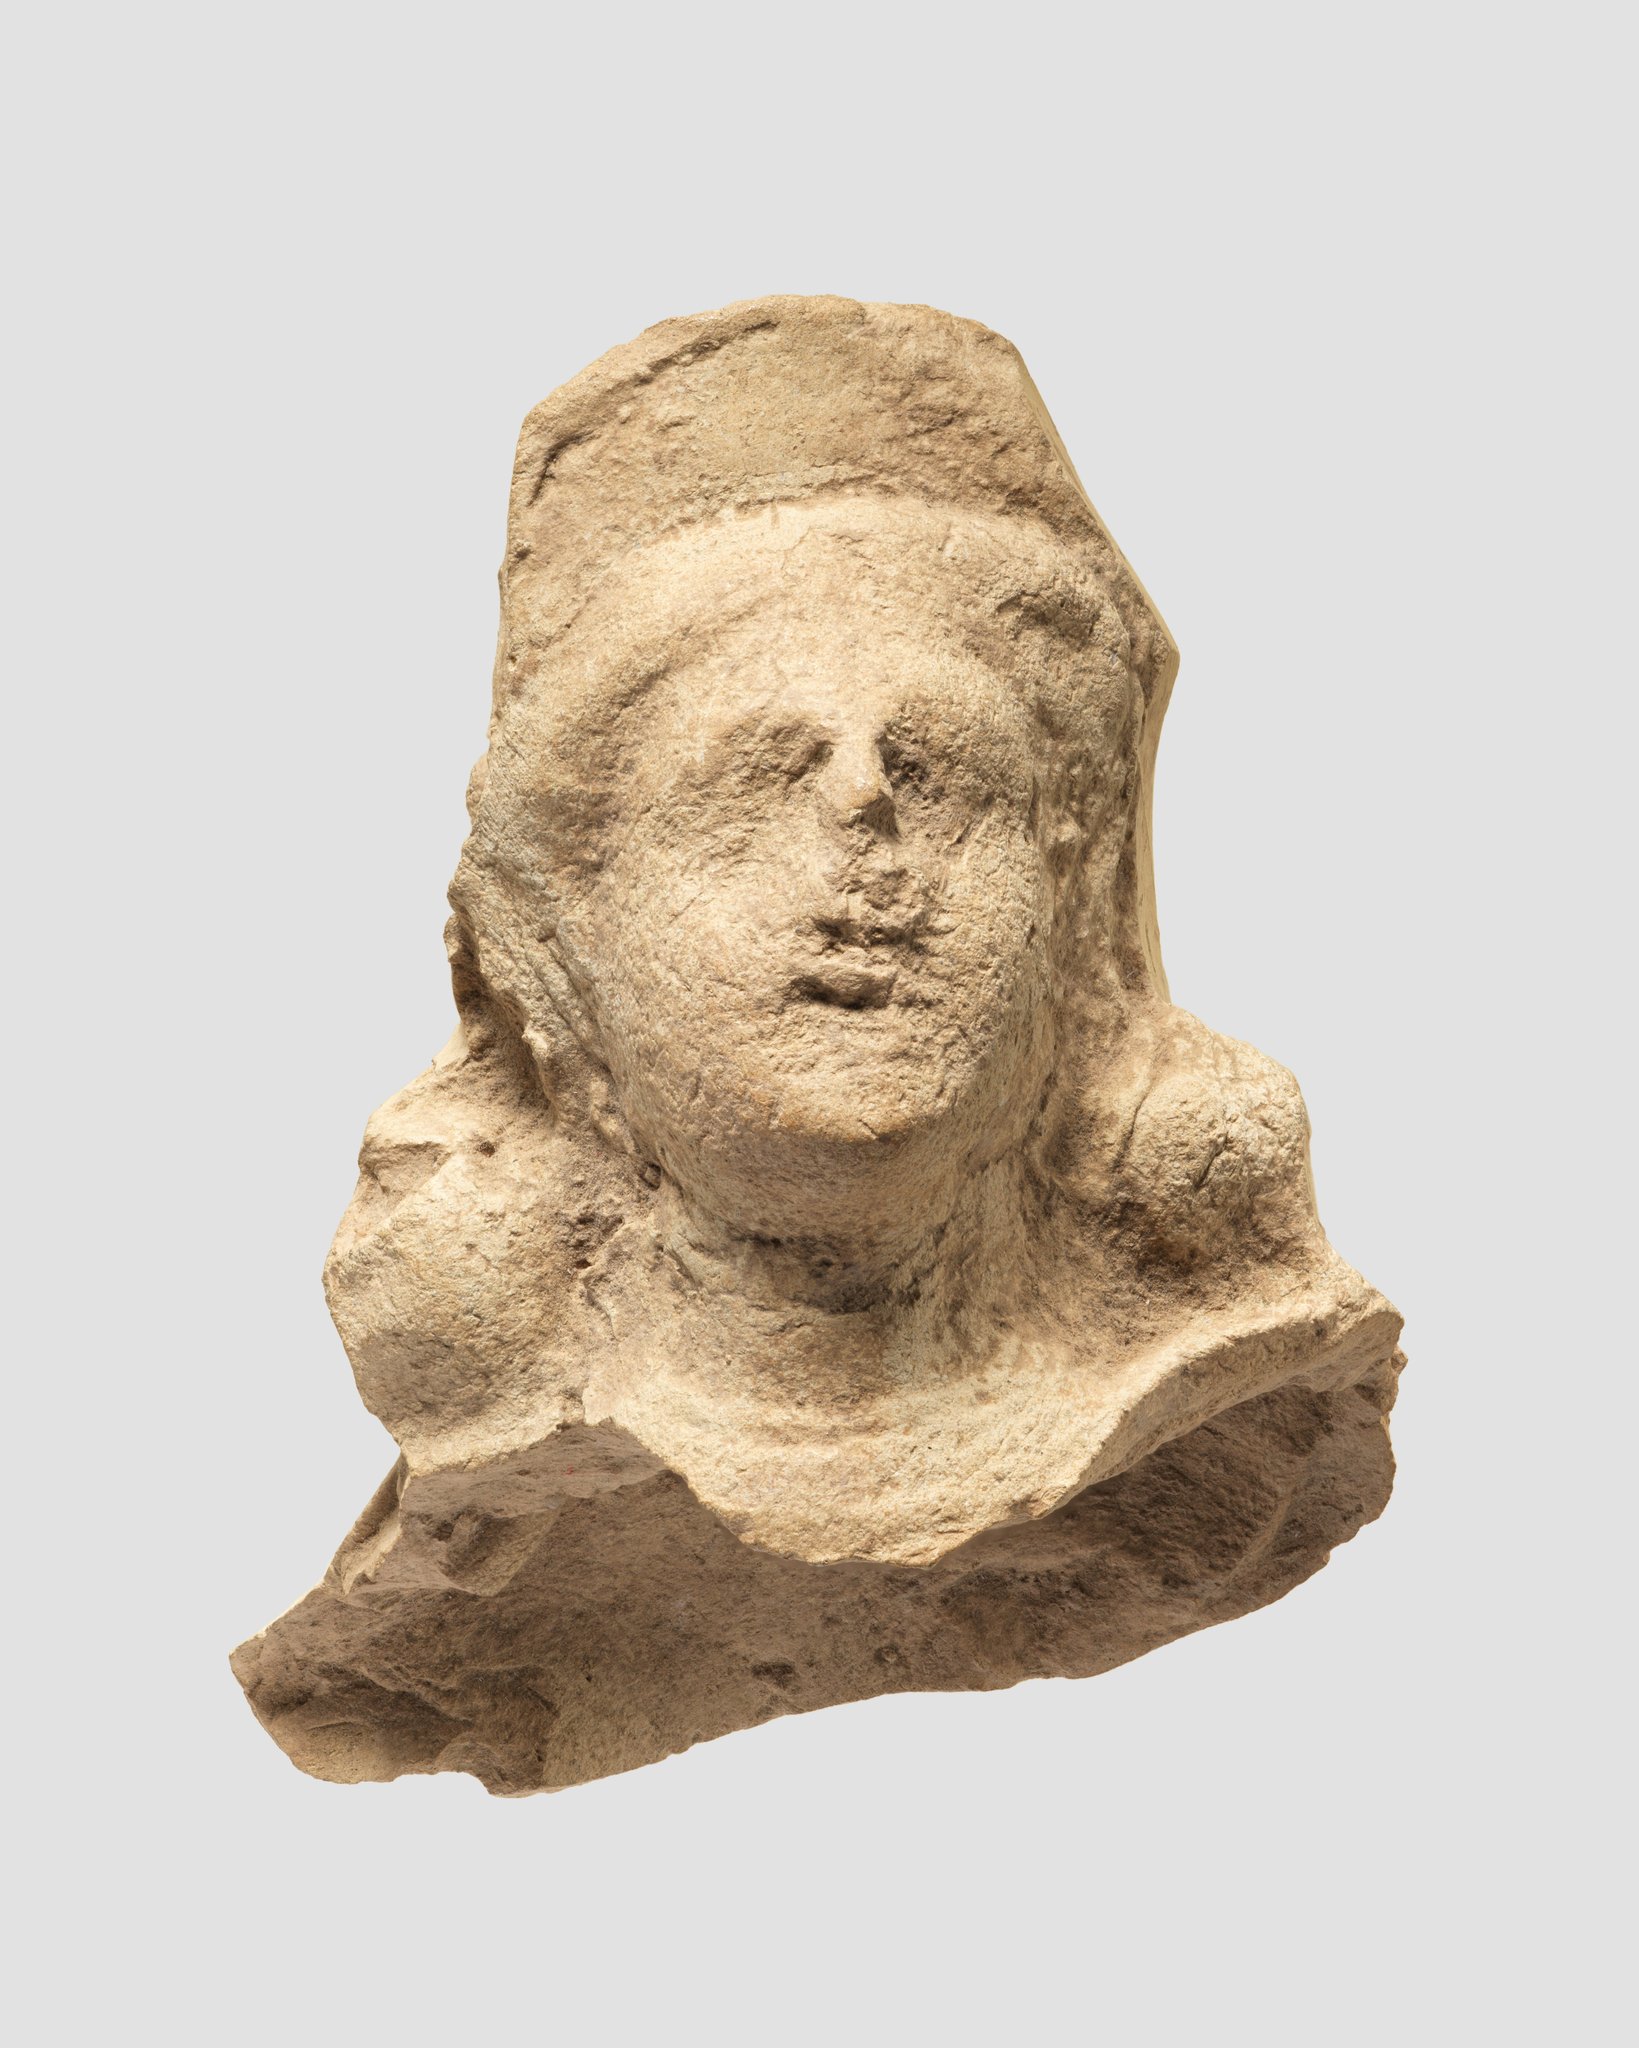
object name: sculpture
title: Head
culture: parthian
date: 101-200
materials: ceramic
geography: mesopotamia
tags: heads